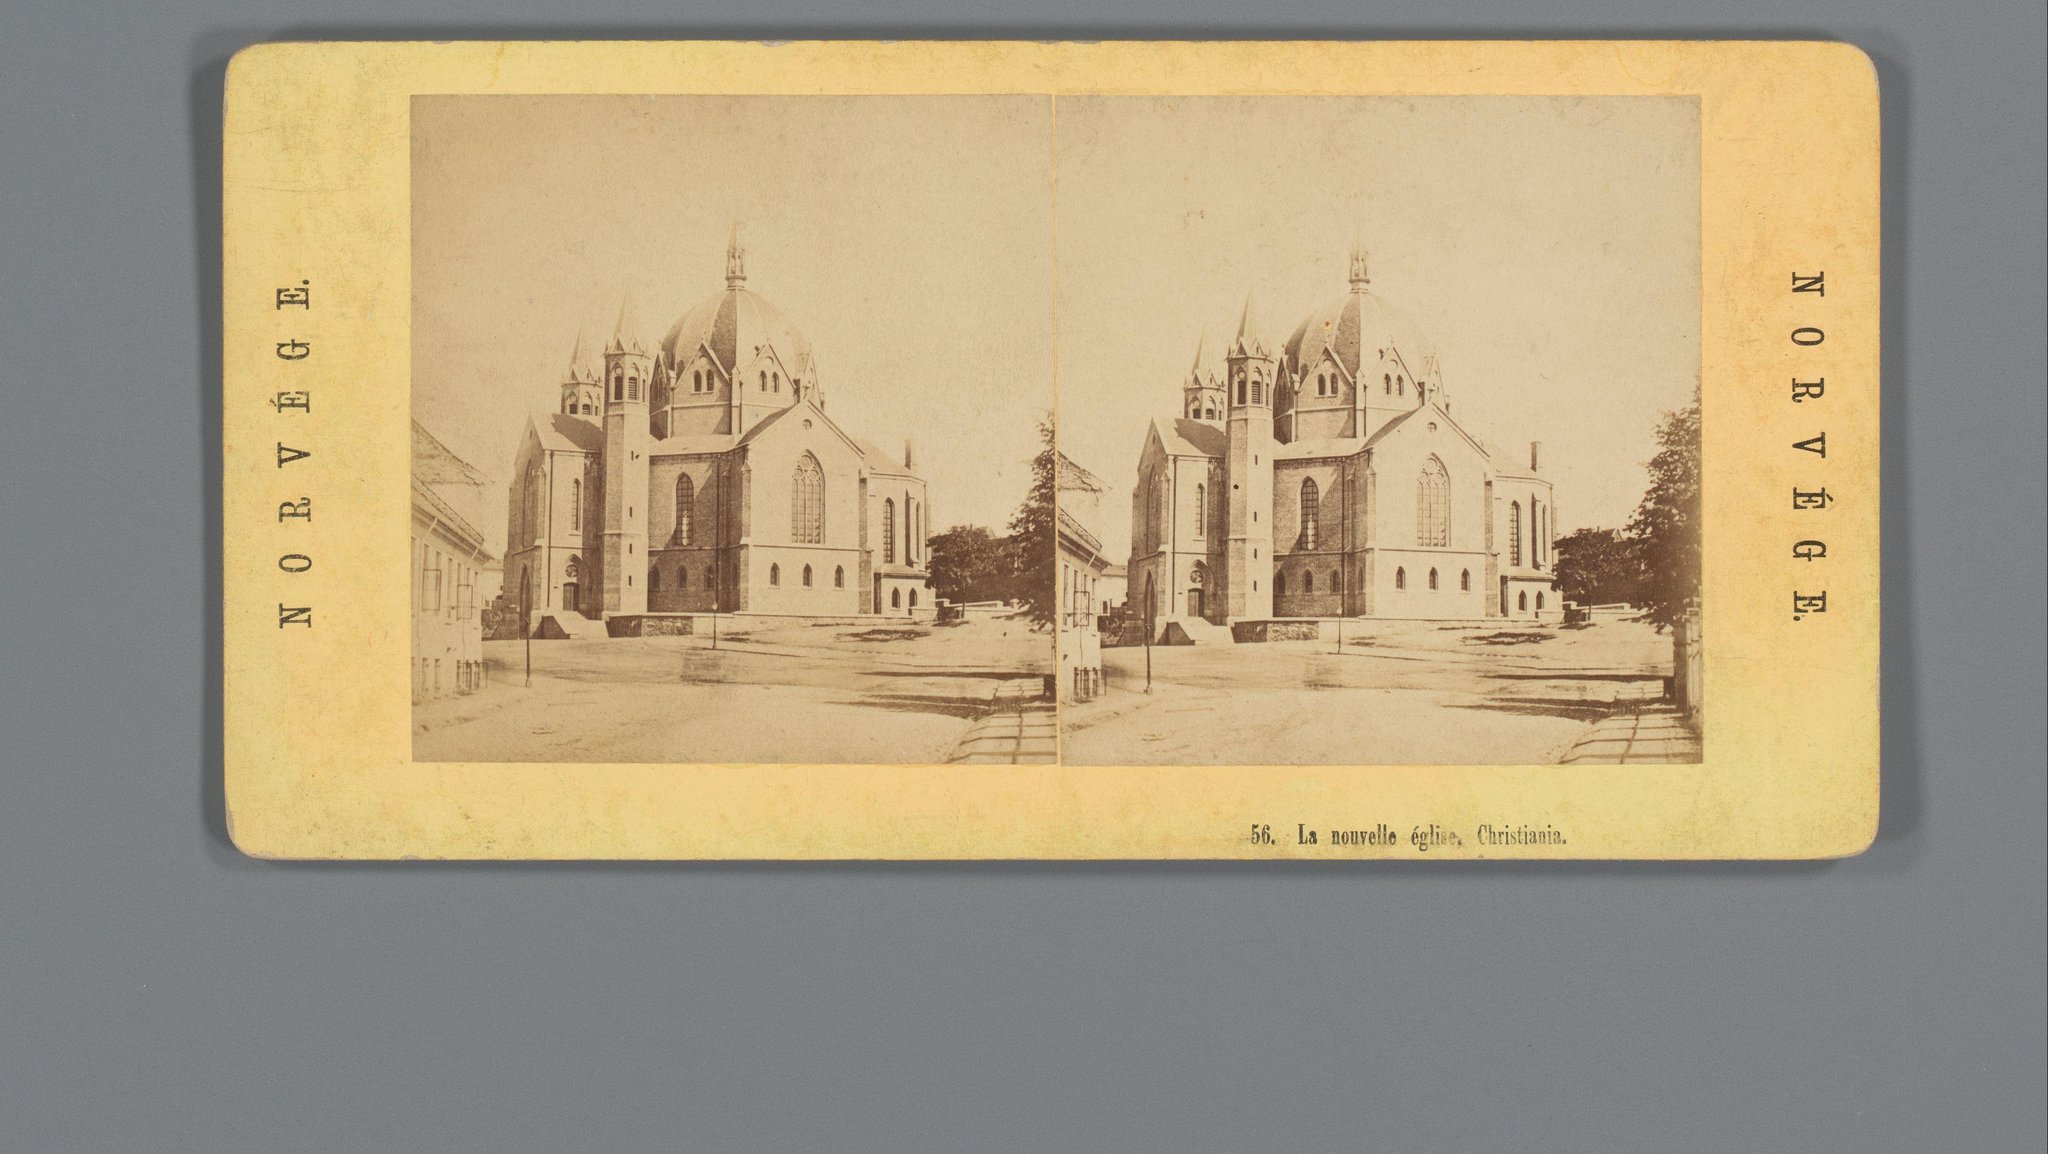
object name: stereograph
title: La nouvelle église, Christiania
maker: Anonymous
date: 1861-1870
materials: cardboard, paper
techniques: albumen print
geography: oslo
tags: church (exterior)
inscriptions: number: ‘56.’